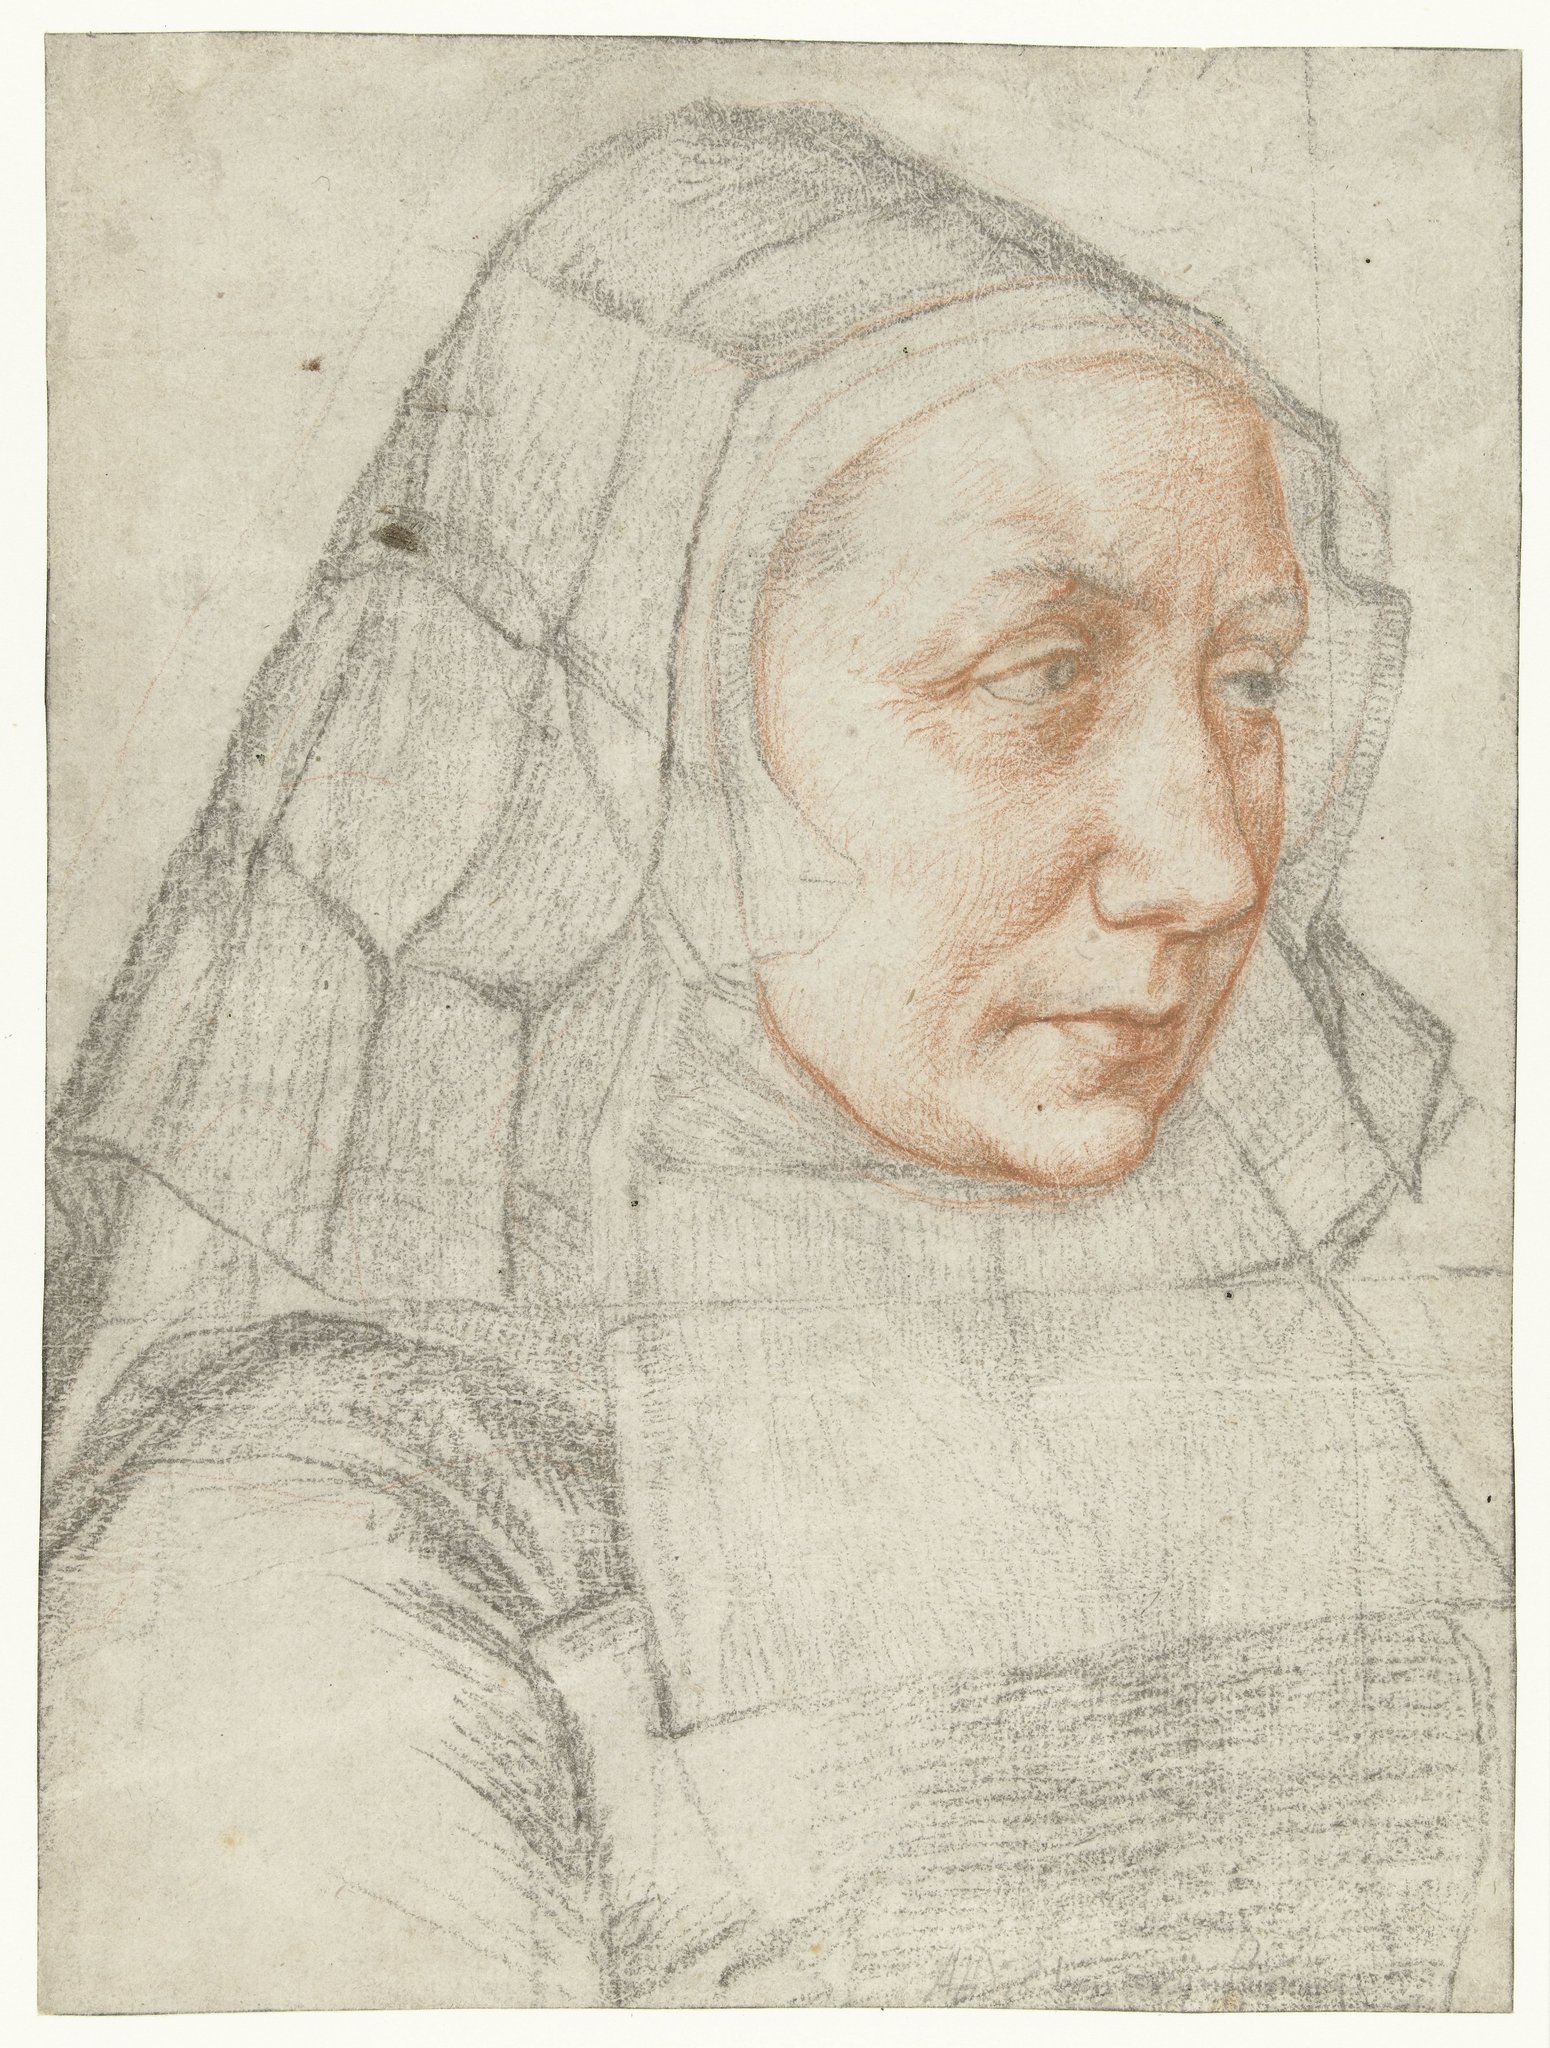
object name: drawing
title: Portret van Elburga van Boetzelaer (?)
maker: wouter pietersz i crabeth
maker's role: designer, draughtsman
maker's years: 1520-1589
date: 1561-1568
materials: chalk, paper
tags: historical persons - bb - woman